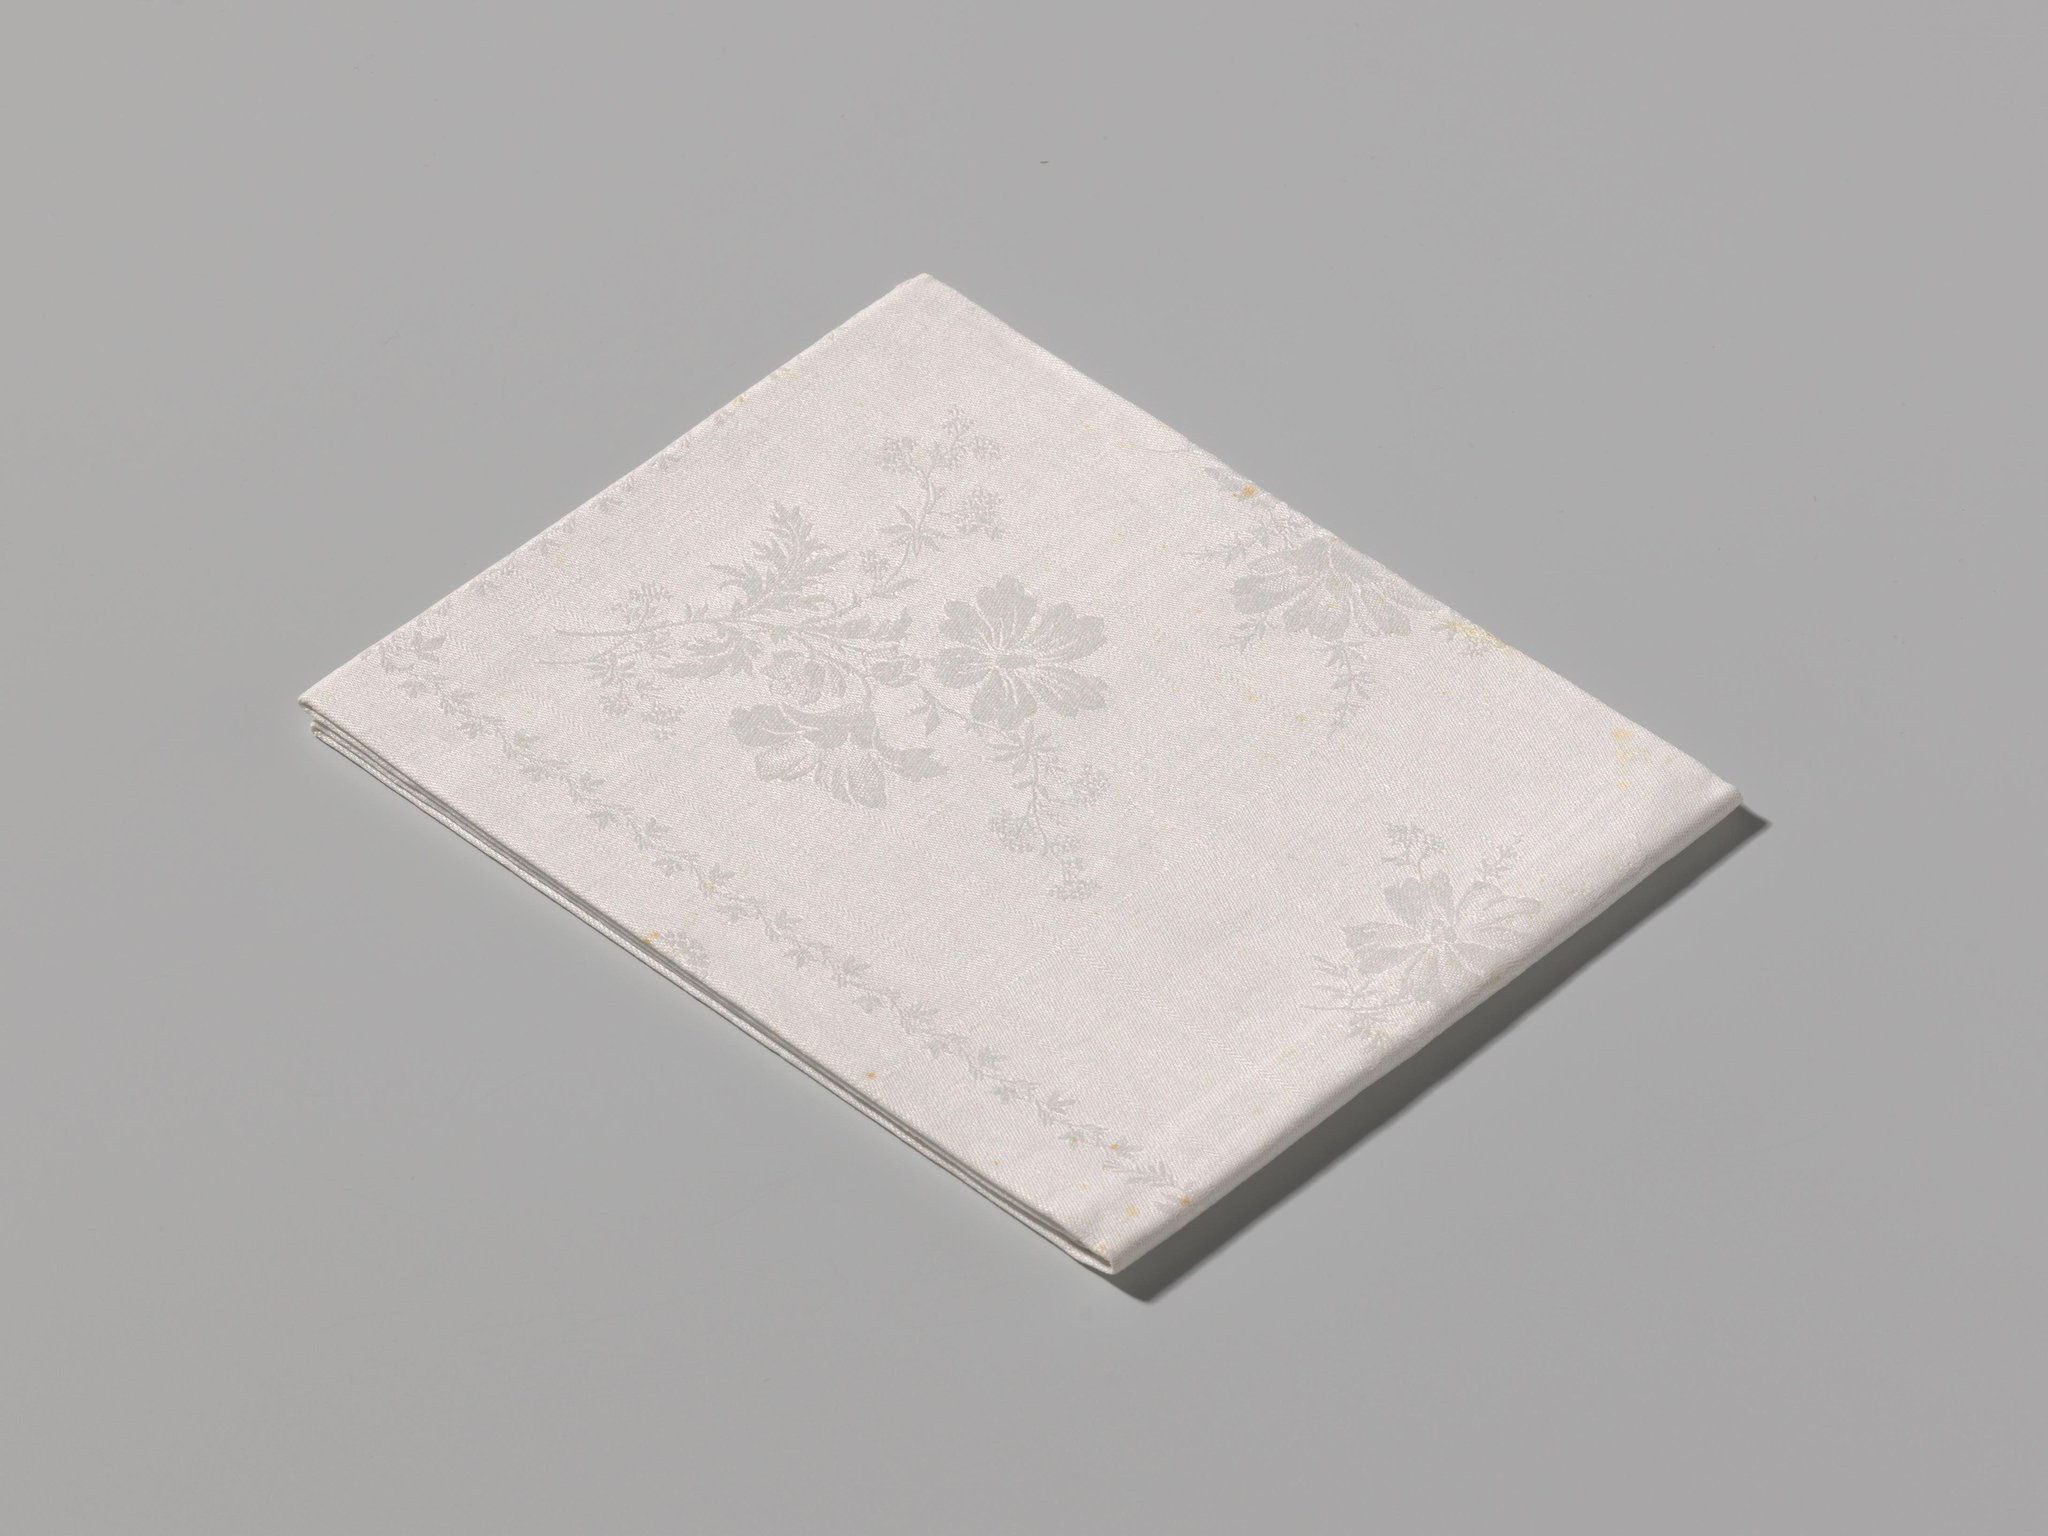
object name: woven material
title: Servet van wit linnendamast met patroon van gestrooide bloem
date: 1800-1900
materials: linen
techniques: damask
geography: netherlands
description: Servet van wit linnendamast met patroon van gestrooide bloem.